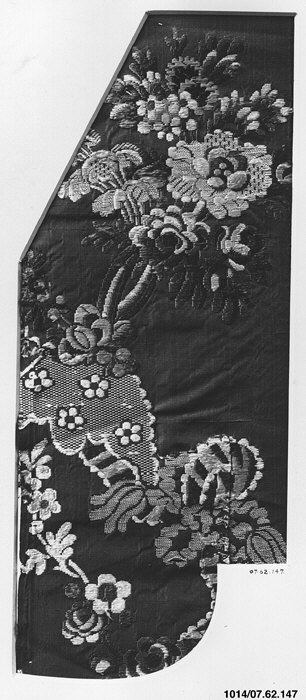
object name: piece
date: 1760-1770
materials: silk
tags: flowers,leaves